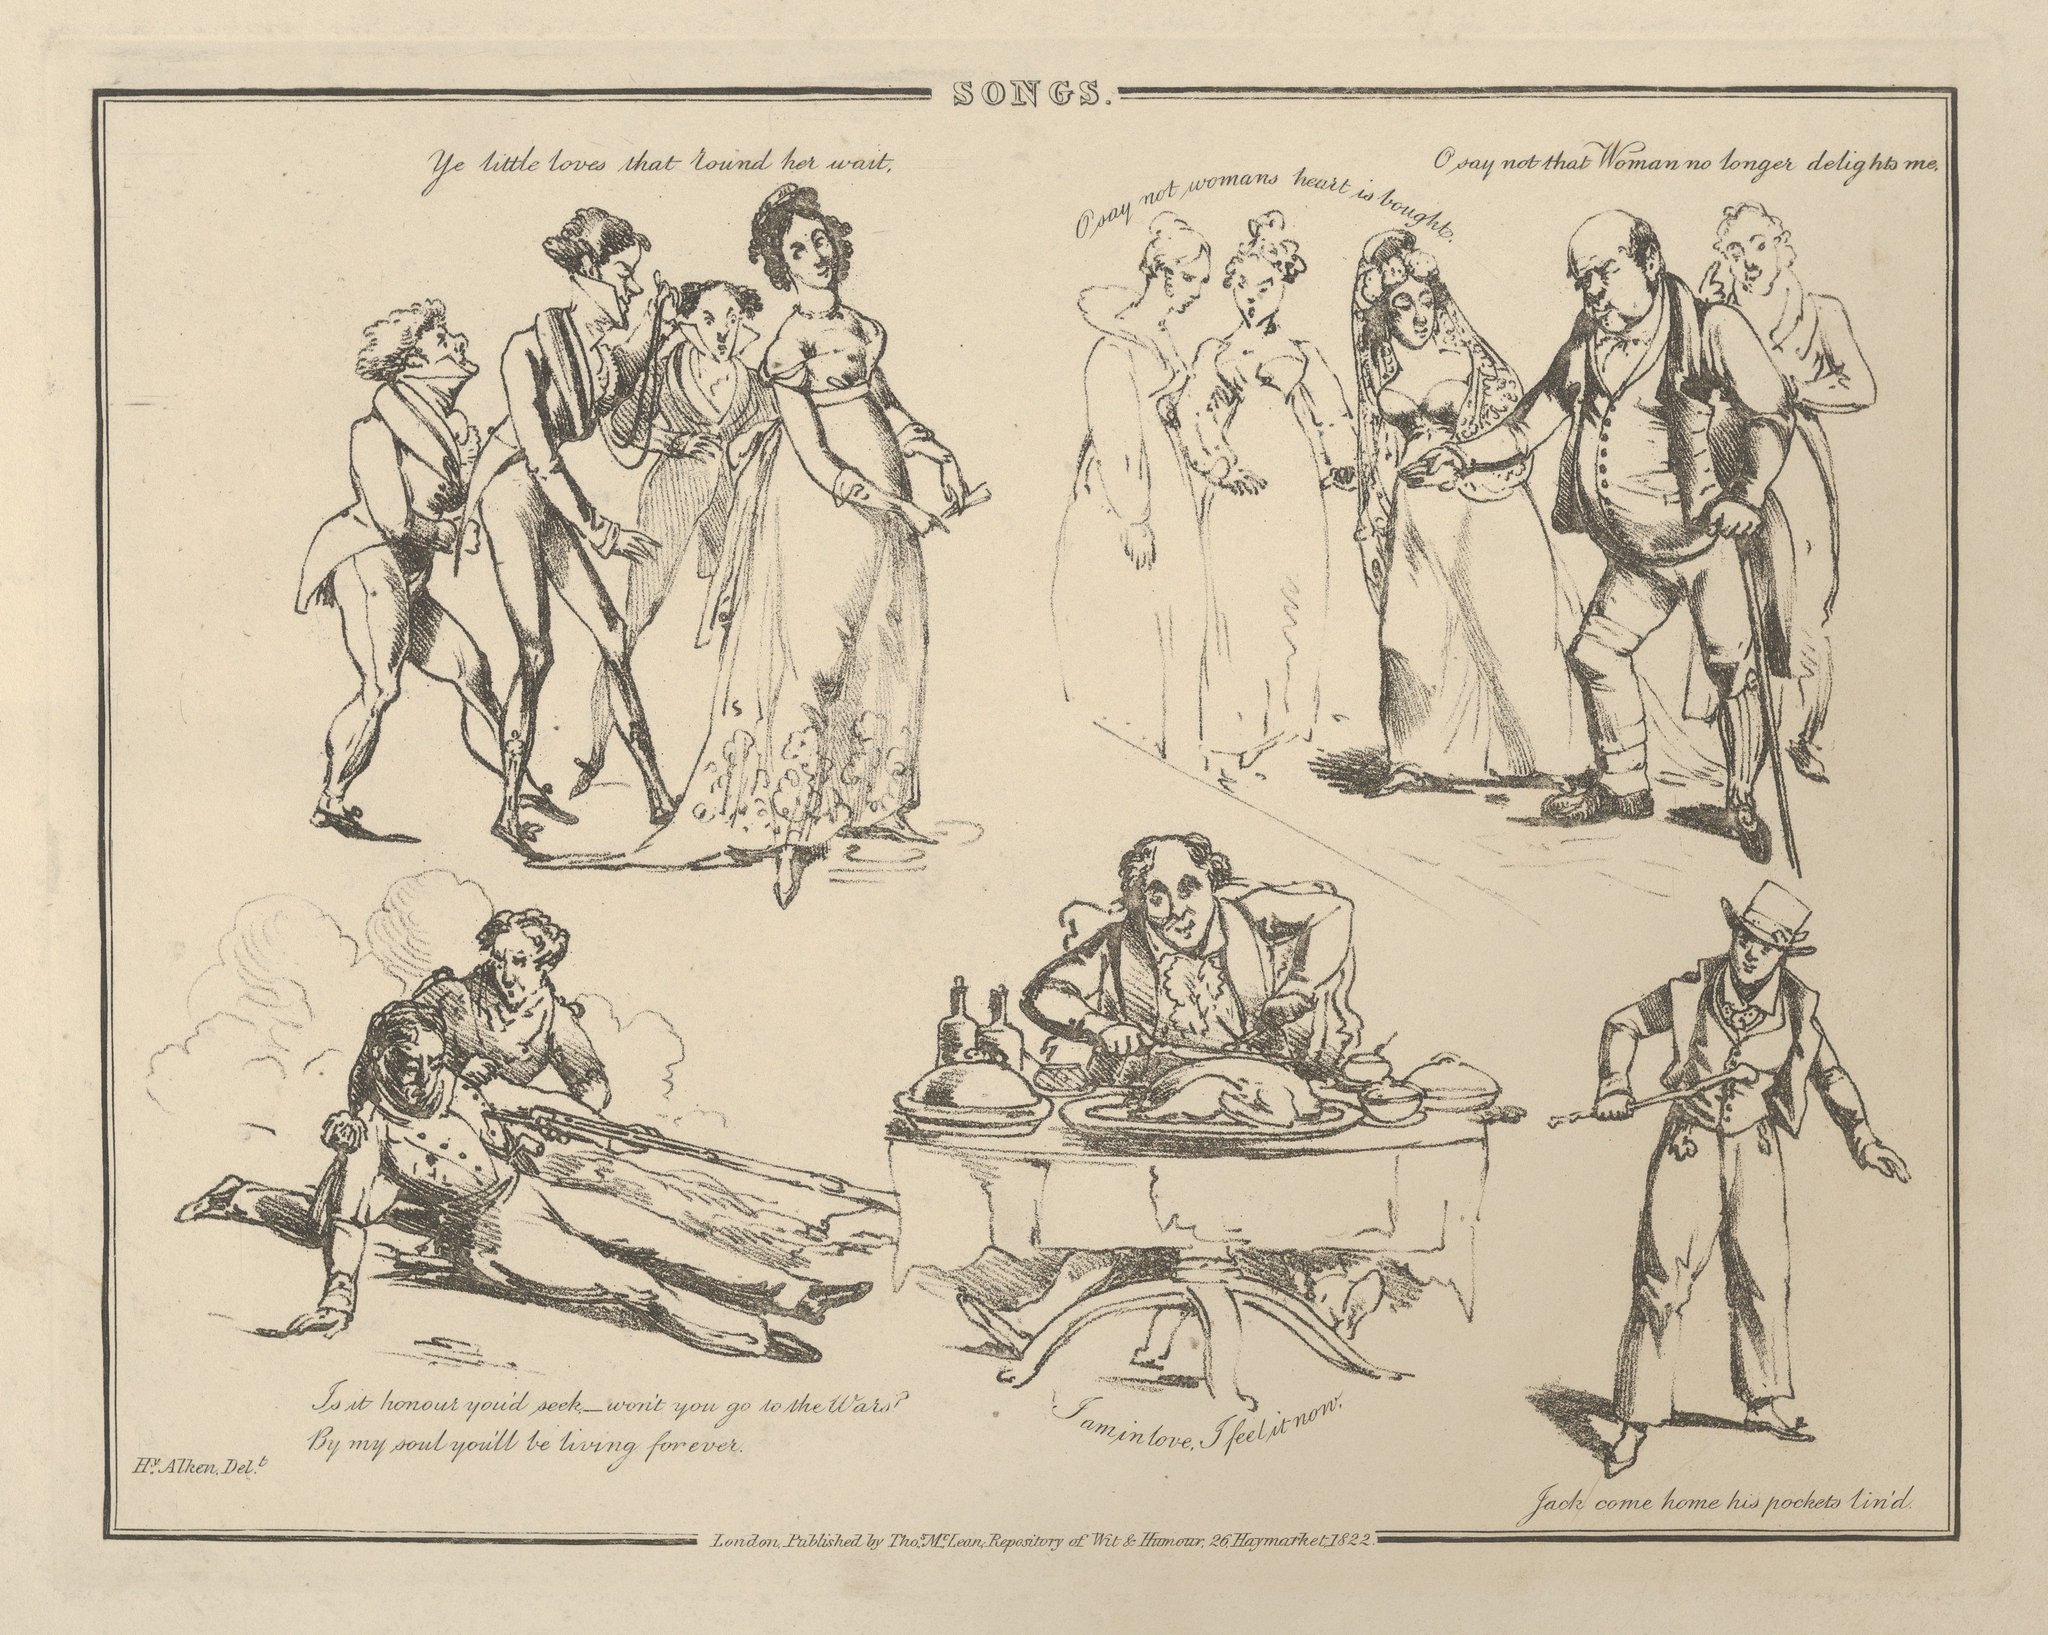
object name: print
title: Songs: "Ye little loves that round her wait..."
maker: henry alken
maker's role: artist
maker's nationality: british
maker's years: 1785-1851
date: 1822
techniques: etching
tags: food,men,women,dining